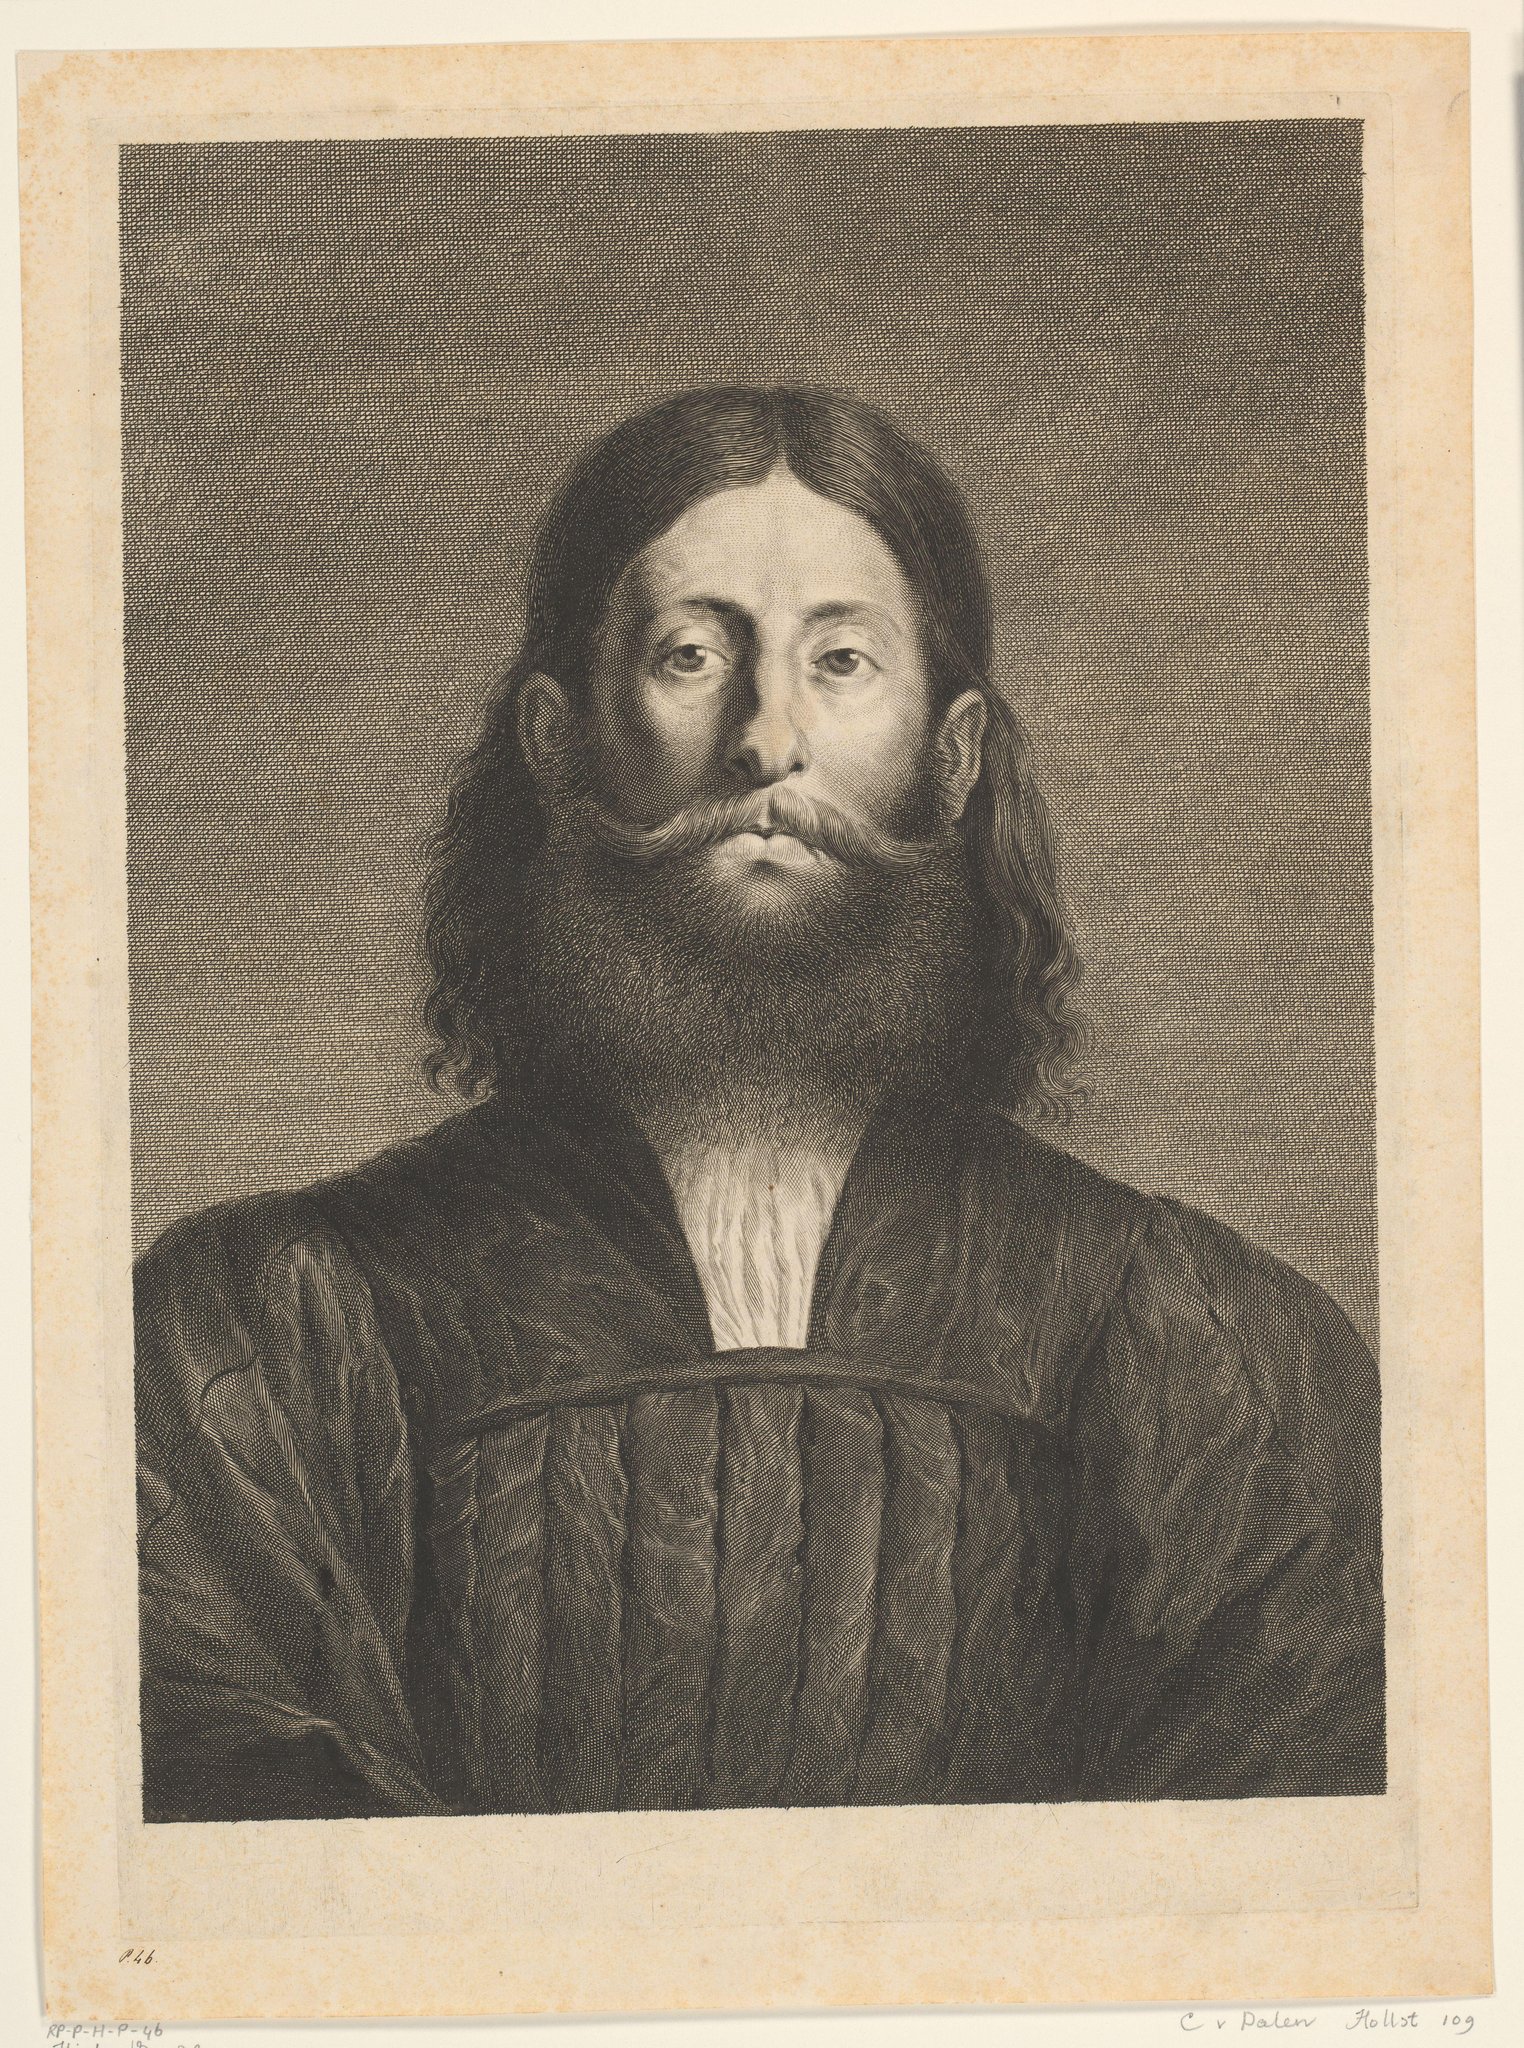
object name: print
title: Portret van schilder Giorgione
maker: cornelis van dalen (ii)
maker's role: draughtsman, print maker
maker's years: 1638-1664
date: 1648-1664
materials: paper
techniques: engraving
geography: amsterdam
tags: painter, giorgione, portrait, self-portrait of painter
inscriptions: collector's mark: Lugt 11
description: Deze prent maakte ten minste tot 1979 deel uit van een prentalbum met de titel: 't Cabinet der Italiaense schilderije antique statue en borstbeelde van de heer Renst 145 stucks. Simon Schijnvoet heeft in 1709 aan dit album het Schijnvoet-nummer 22, liber nummer 20 toegekend. Prent uit serie Caelaturae met vierendertig reprodukties naar Italiaanse en Nederlandse schilders, vervaardigd door de allerbeste graveurs in opdracht van de verzamelaar Gerard Reynst.